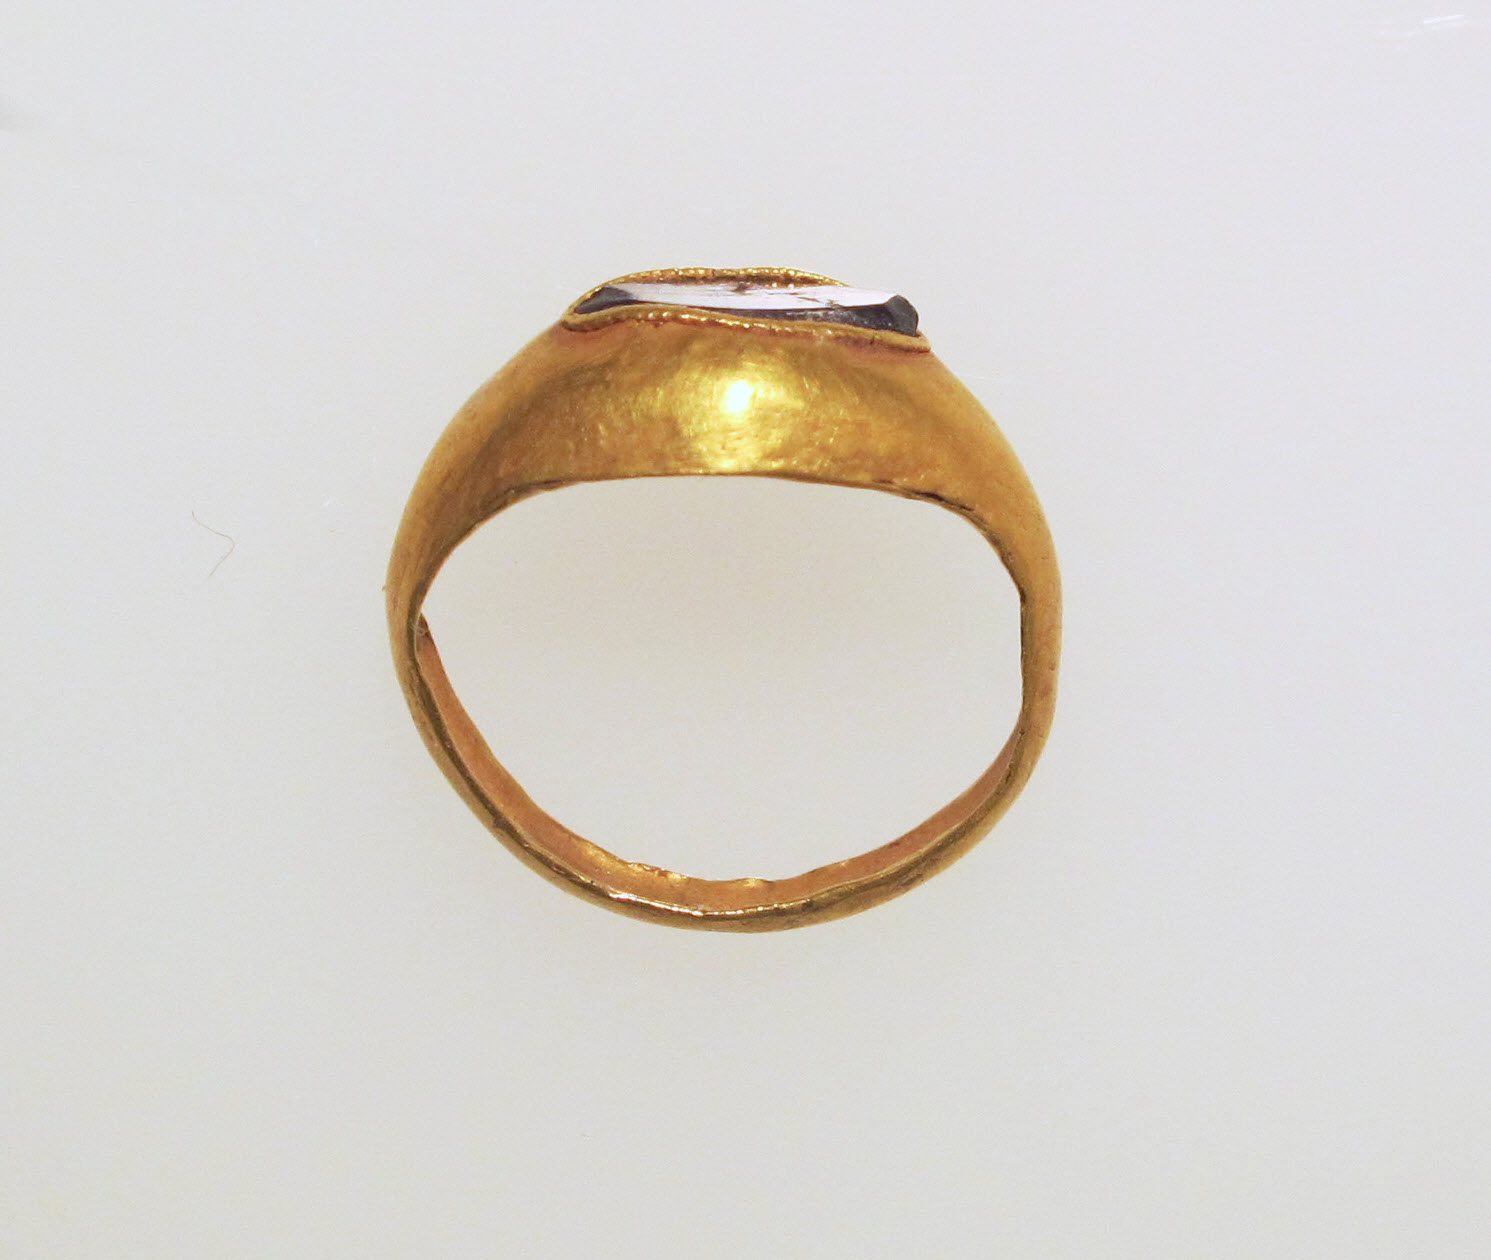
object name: ring with garnet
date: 7000 BCE-330 CE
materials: gemstone, gold